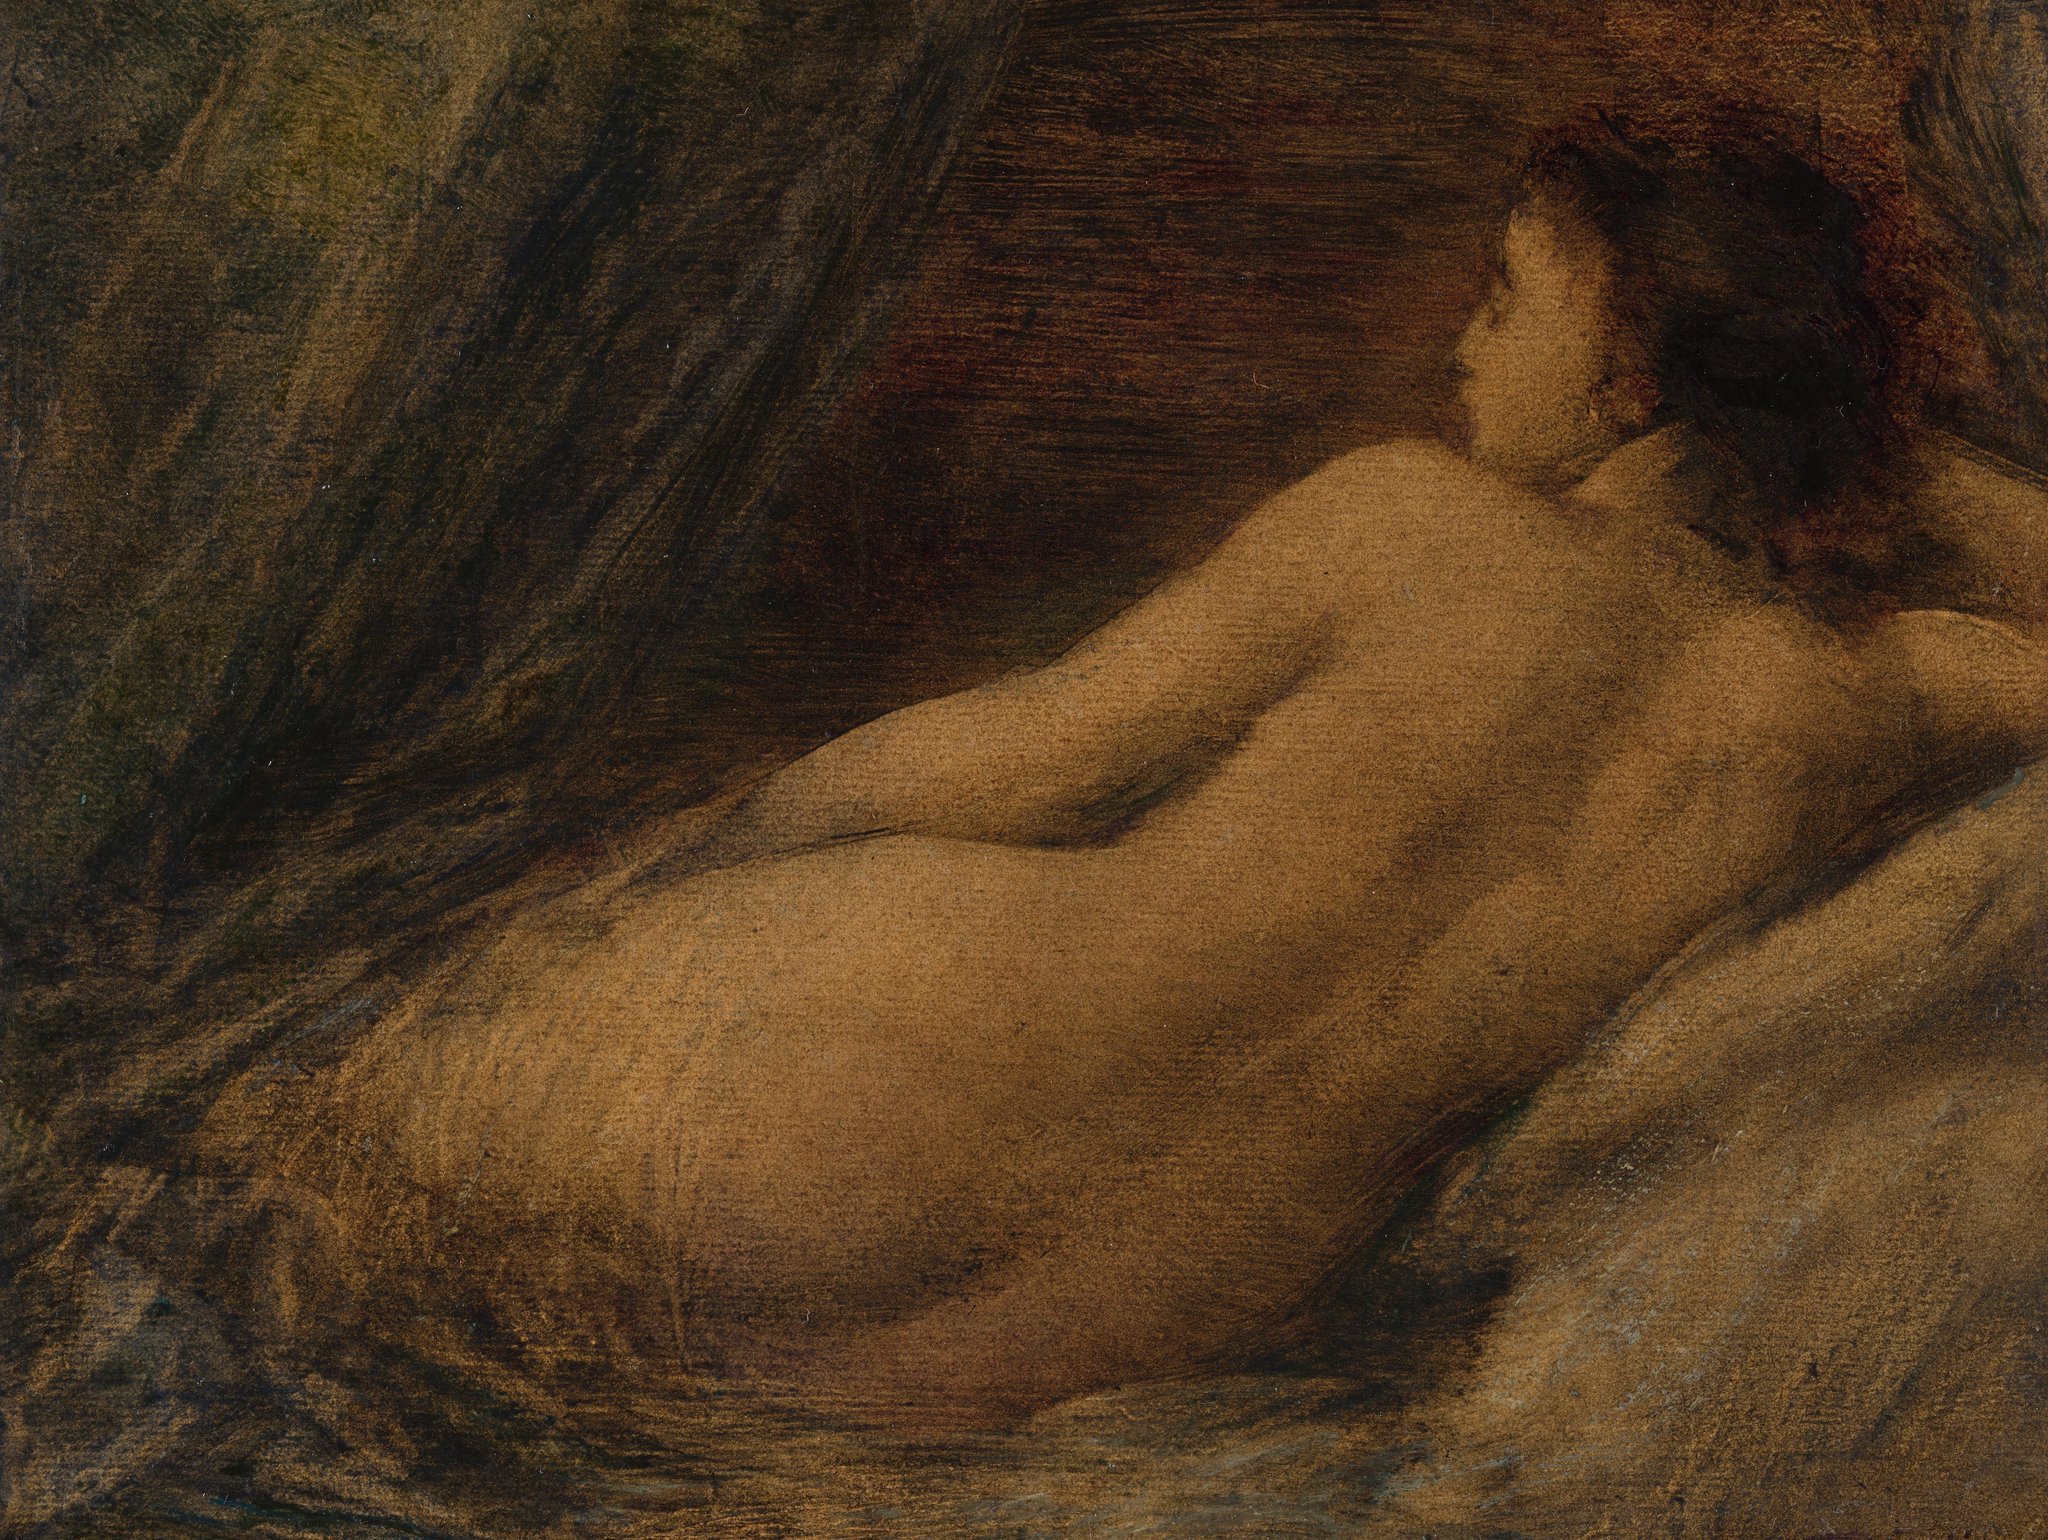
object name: painting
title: Reclining Nude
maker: henri fantin-latour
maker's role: draughtsman, print maker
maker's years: 1836-1904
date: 1874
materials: canvas, oil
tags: lying figure - aa - female human figure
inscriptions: signature and date: ‘Fantin 74’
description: Studie van een naakte vrouw liggend op een sofa of bed, op de rug gezien.